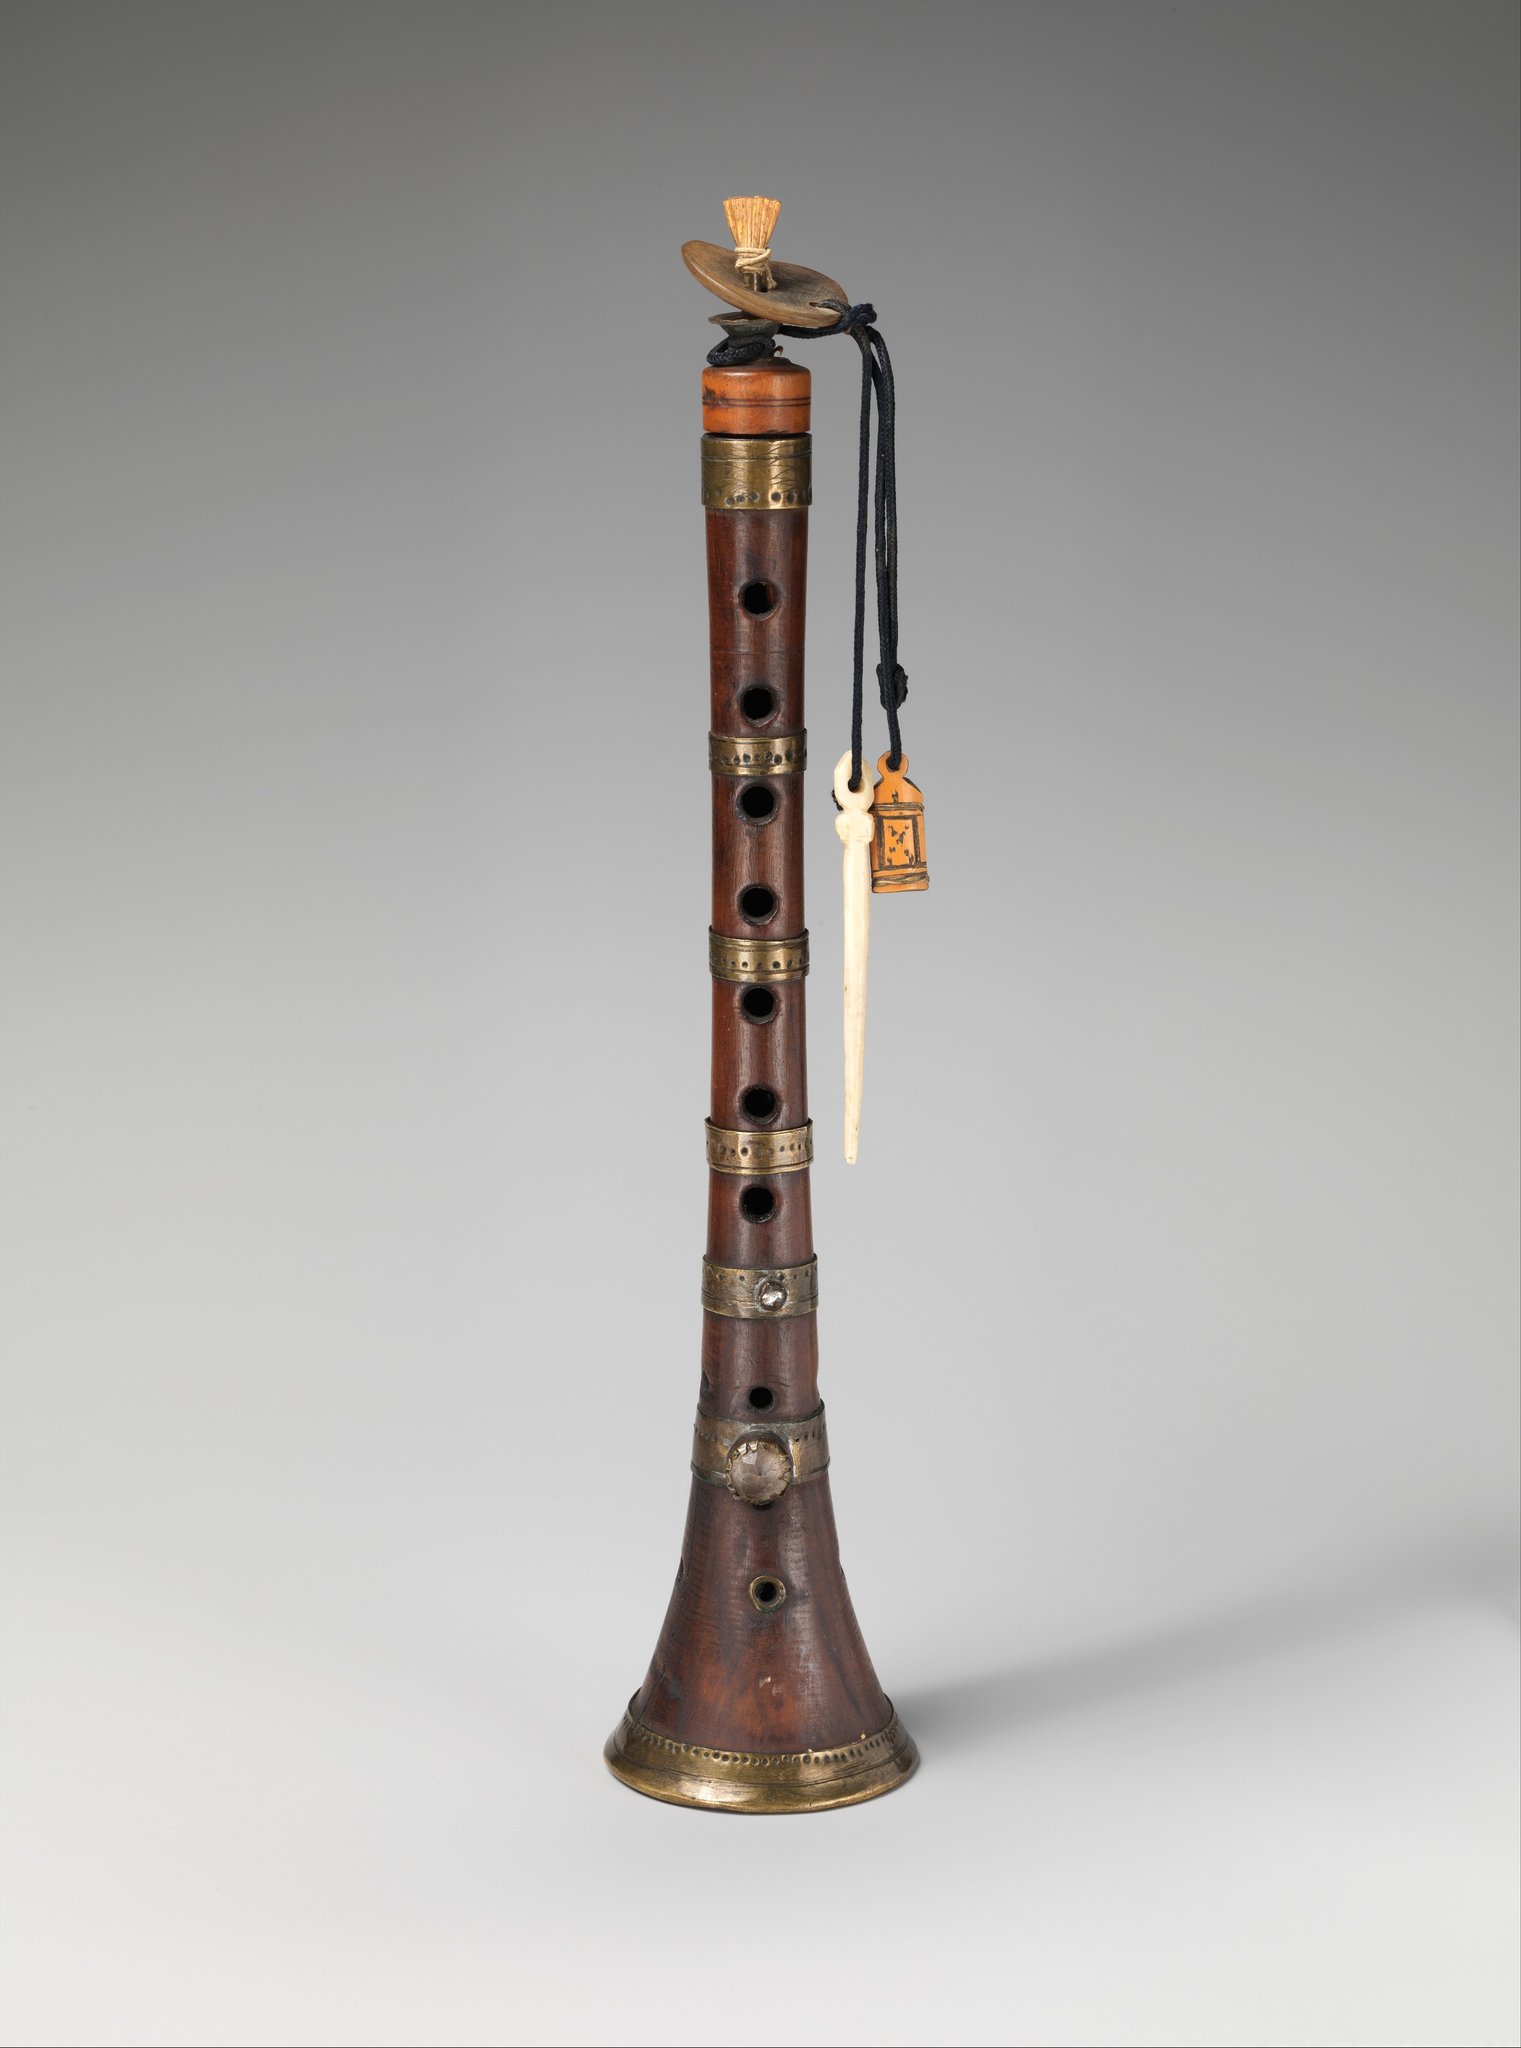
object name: sorna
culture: iranian or persian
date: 1867-1900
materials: bone, brass, horn, wood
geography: iran